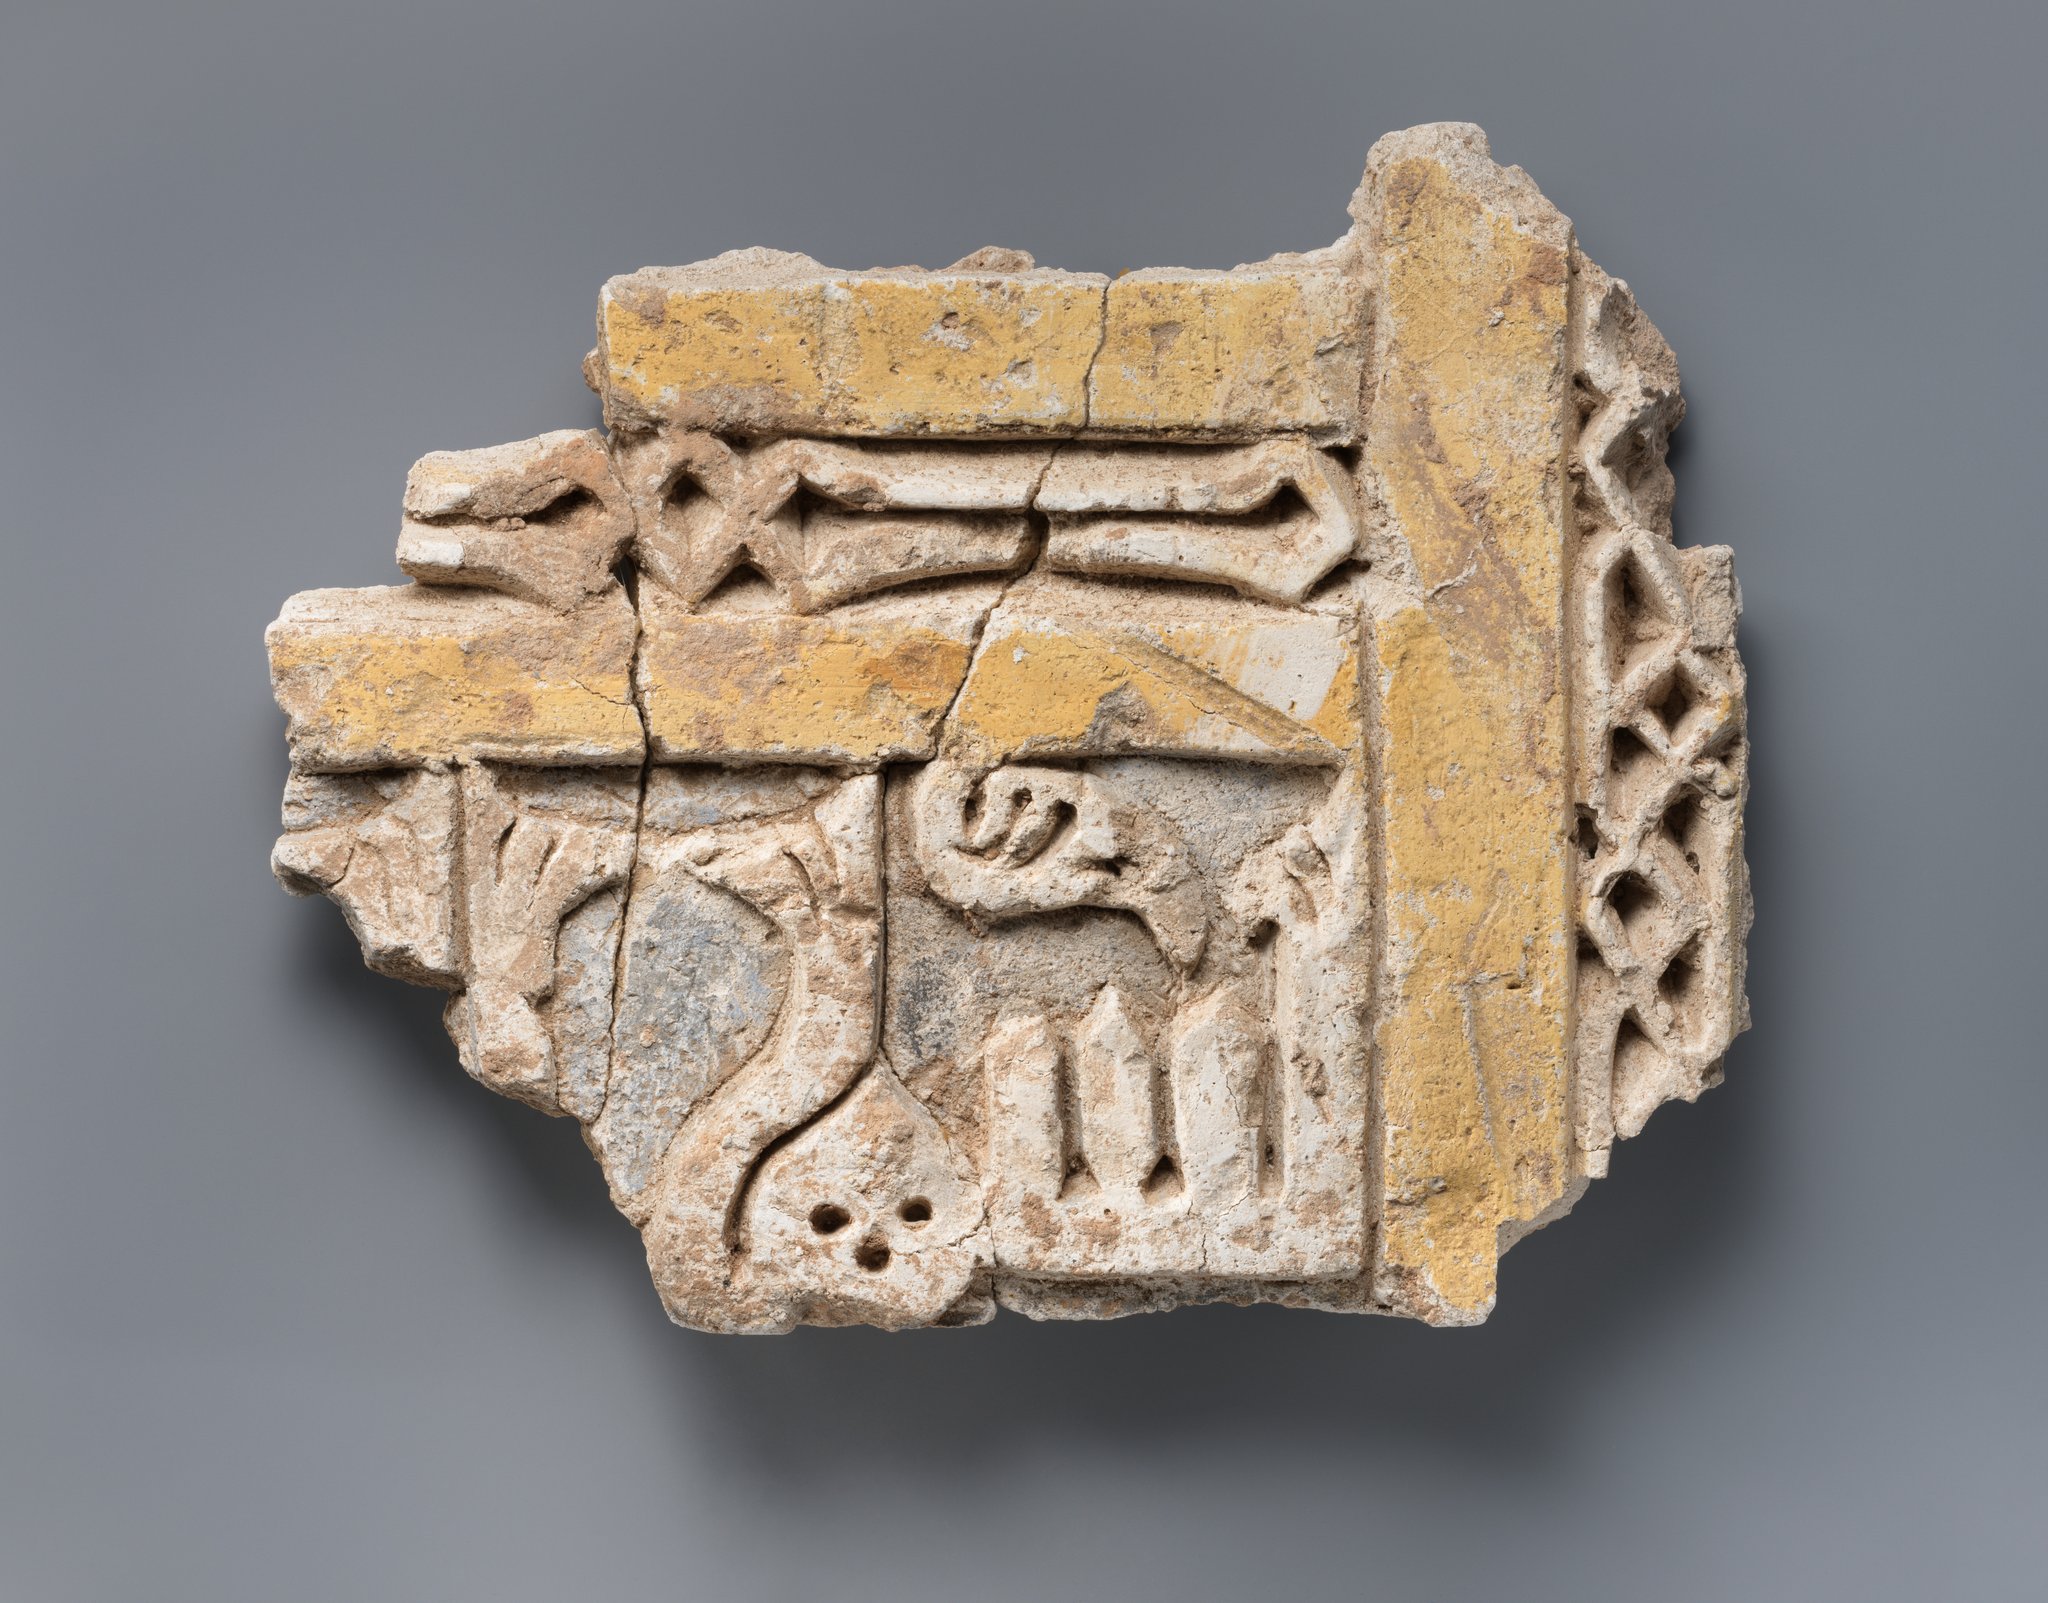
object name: fragment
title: Fragment of a Panel with an Inscription Starting with the Basmala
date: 701-1200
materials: plaster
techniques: carving, painting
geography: iran